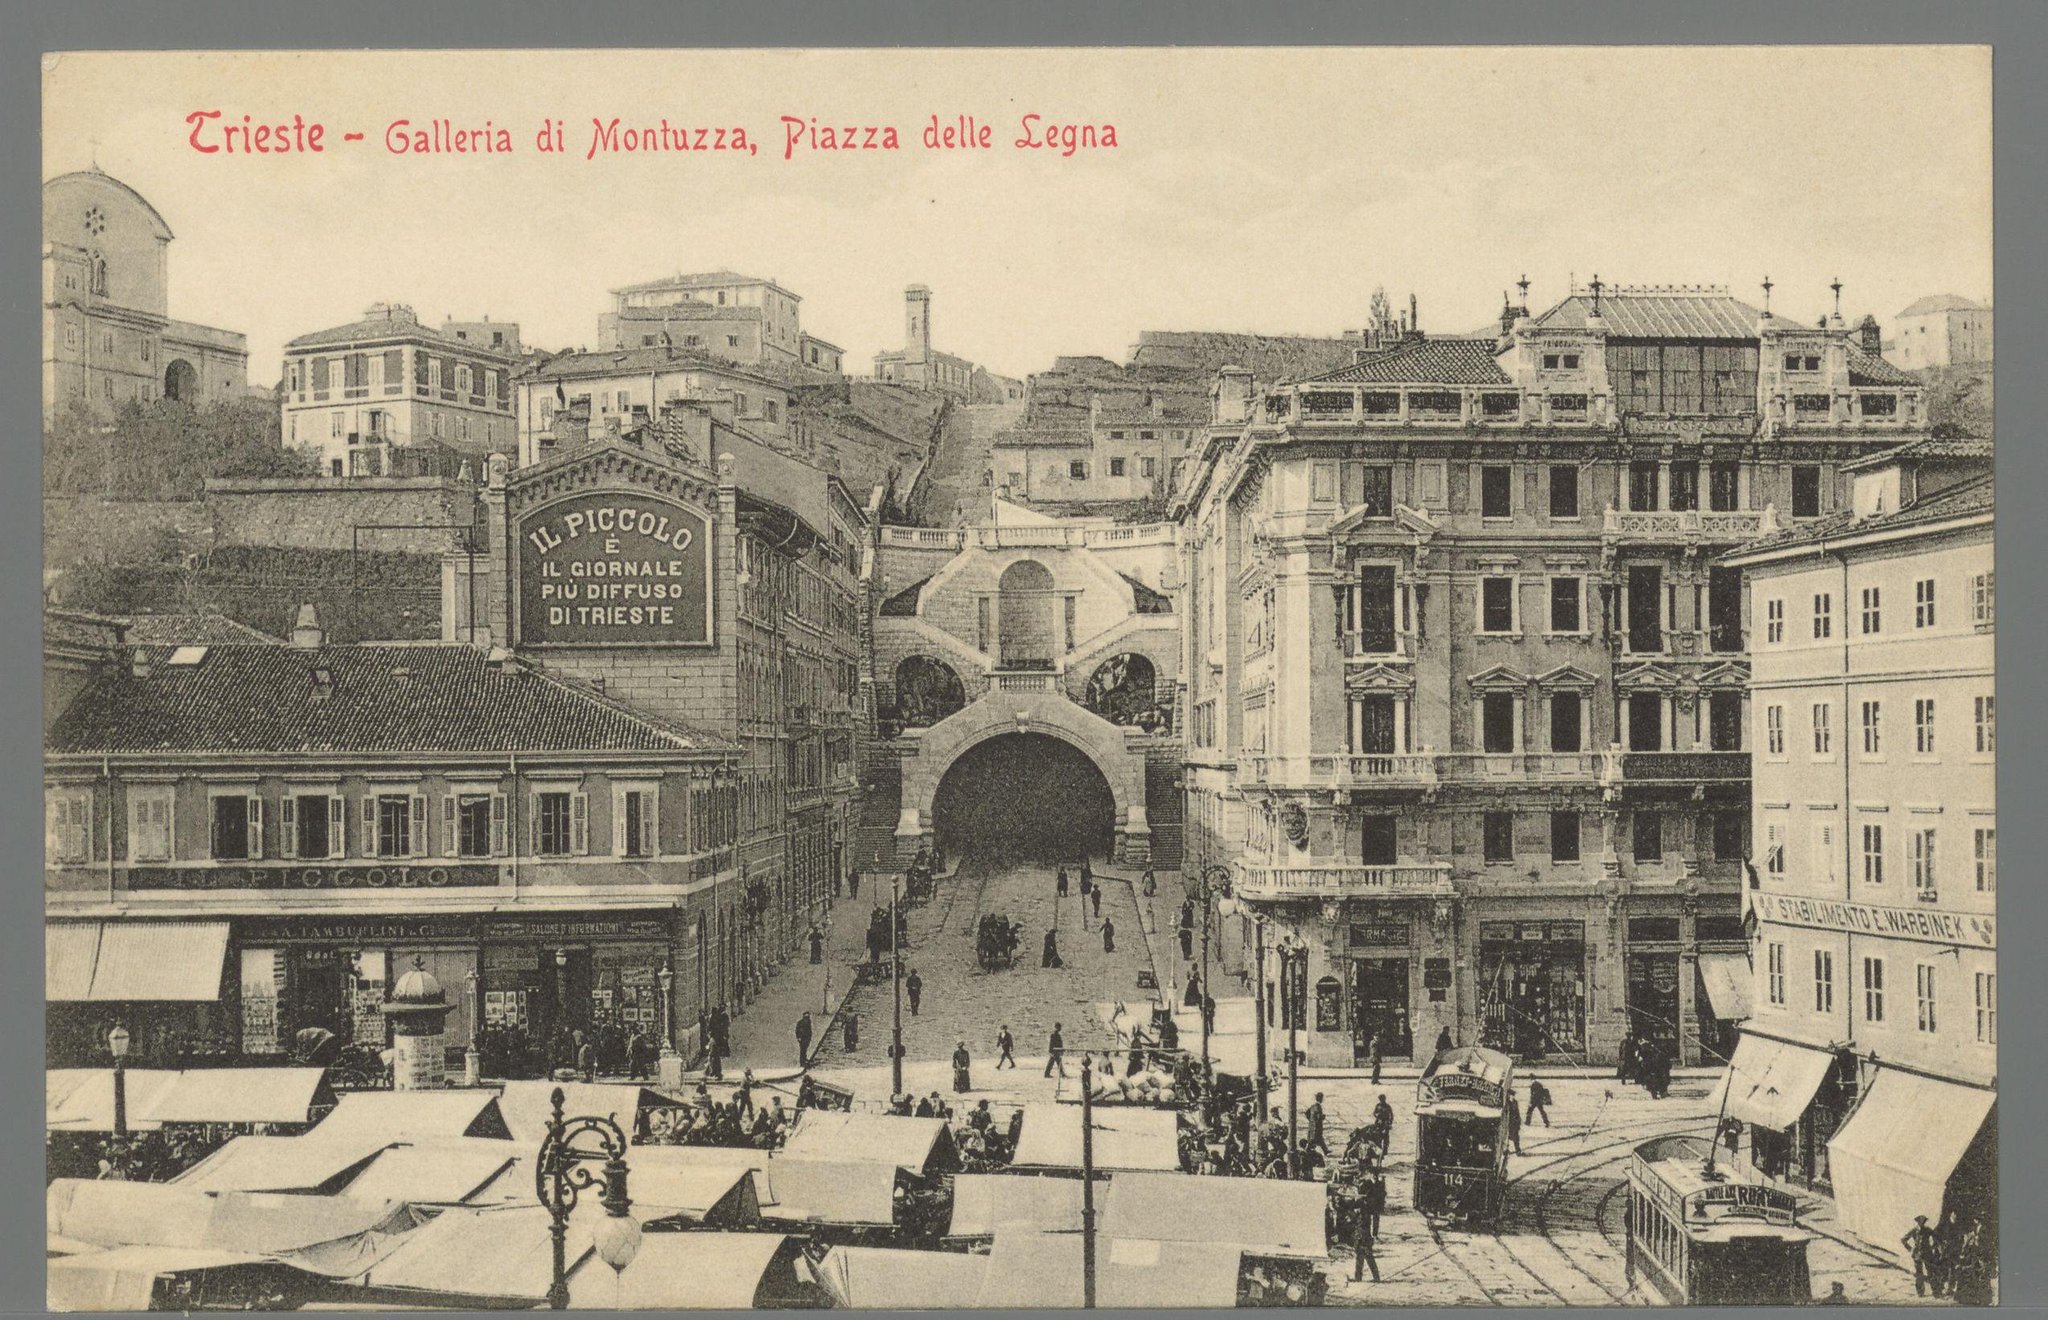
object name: ansichtkaart, prentbriefkaart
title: Trieste. Galleria di Montuzza. Piazza delle Legna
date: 1908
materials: cardboard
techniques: photograph, writing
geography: trieste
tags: urban housing, city-view, and landscape with man-made constructions (+ city(-scape) with figures, staffage)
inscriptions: date